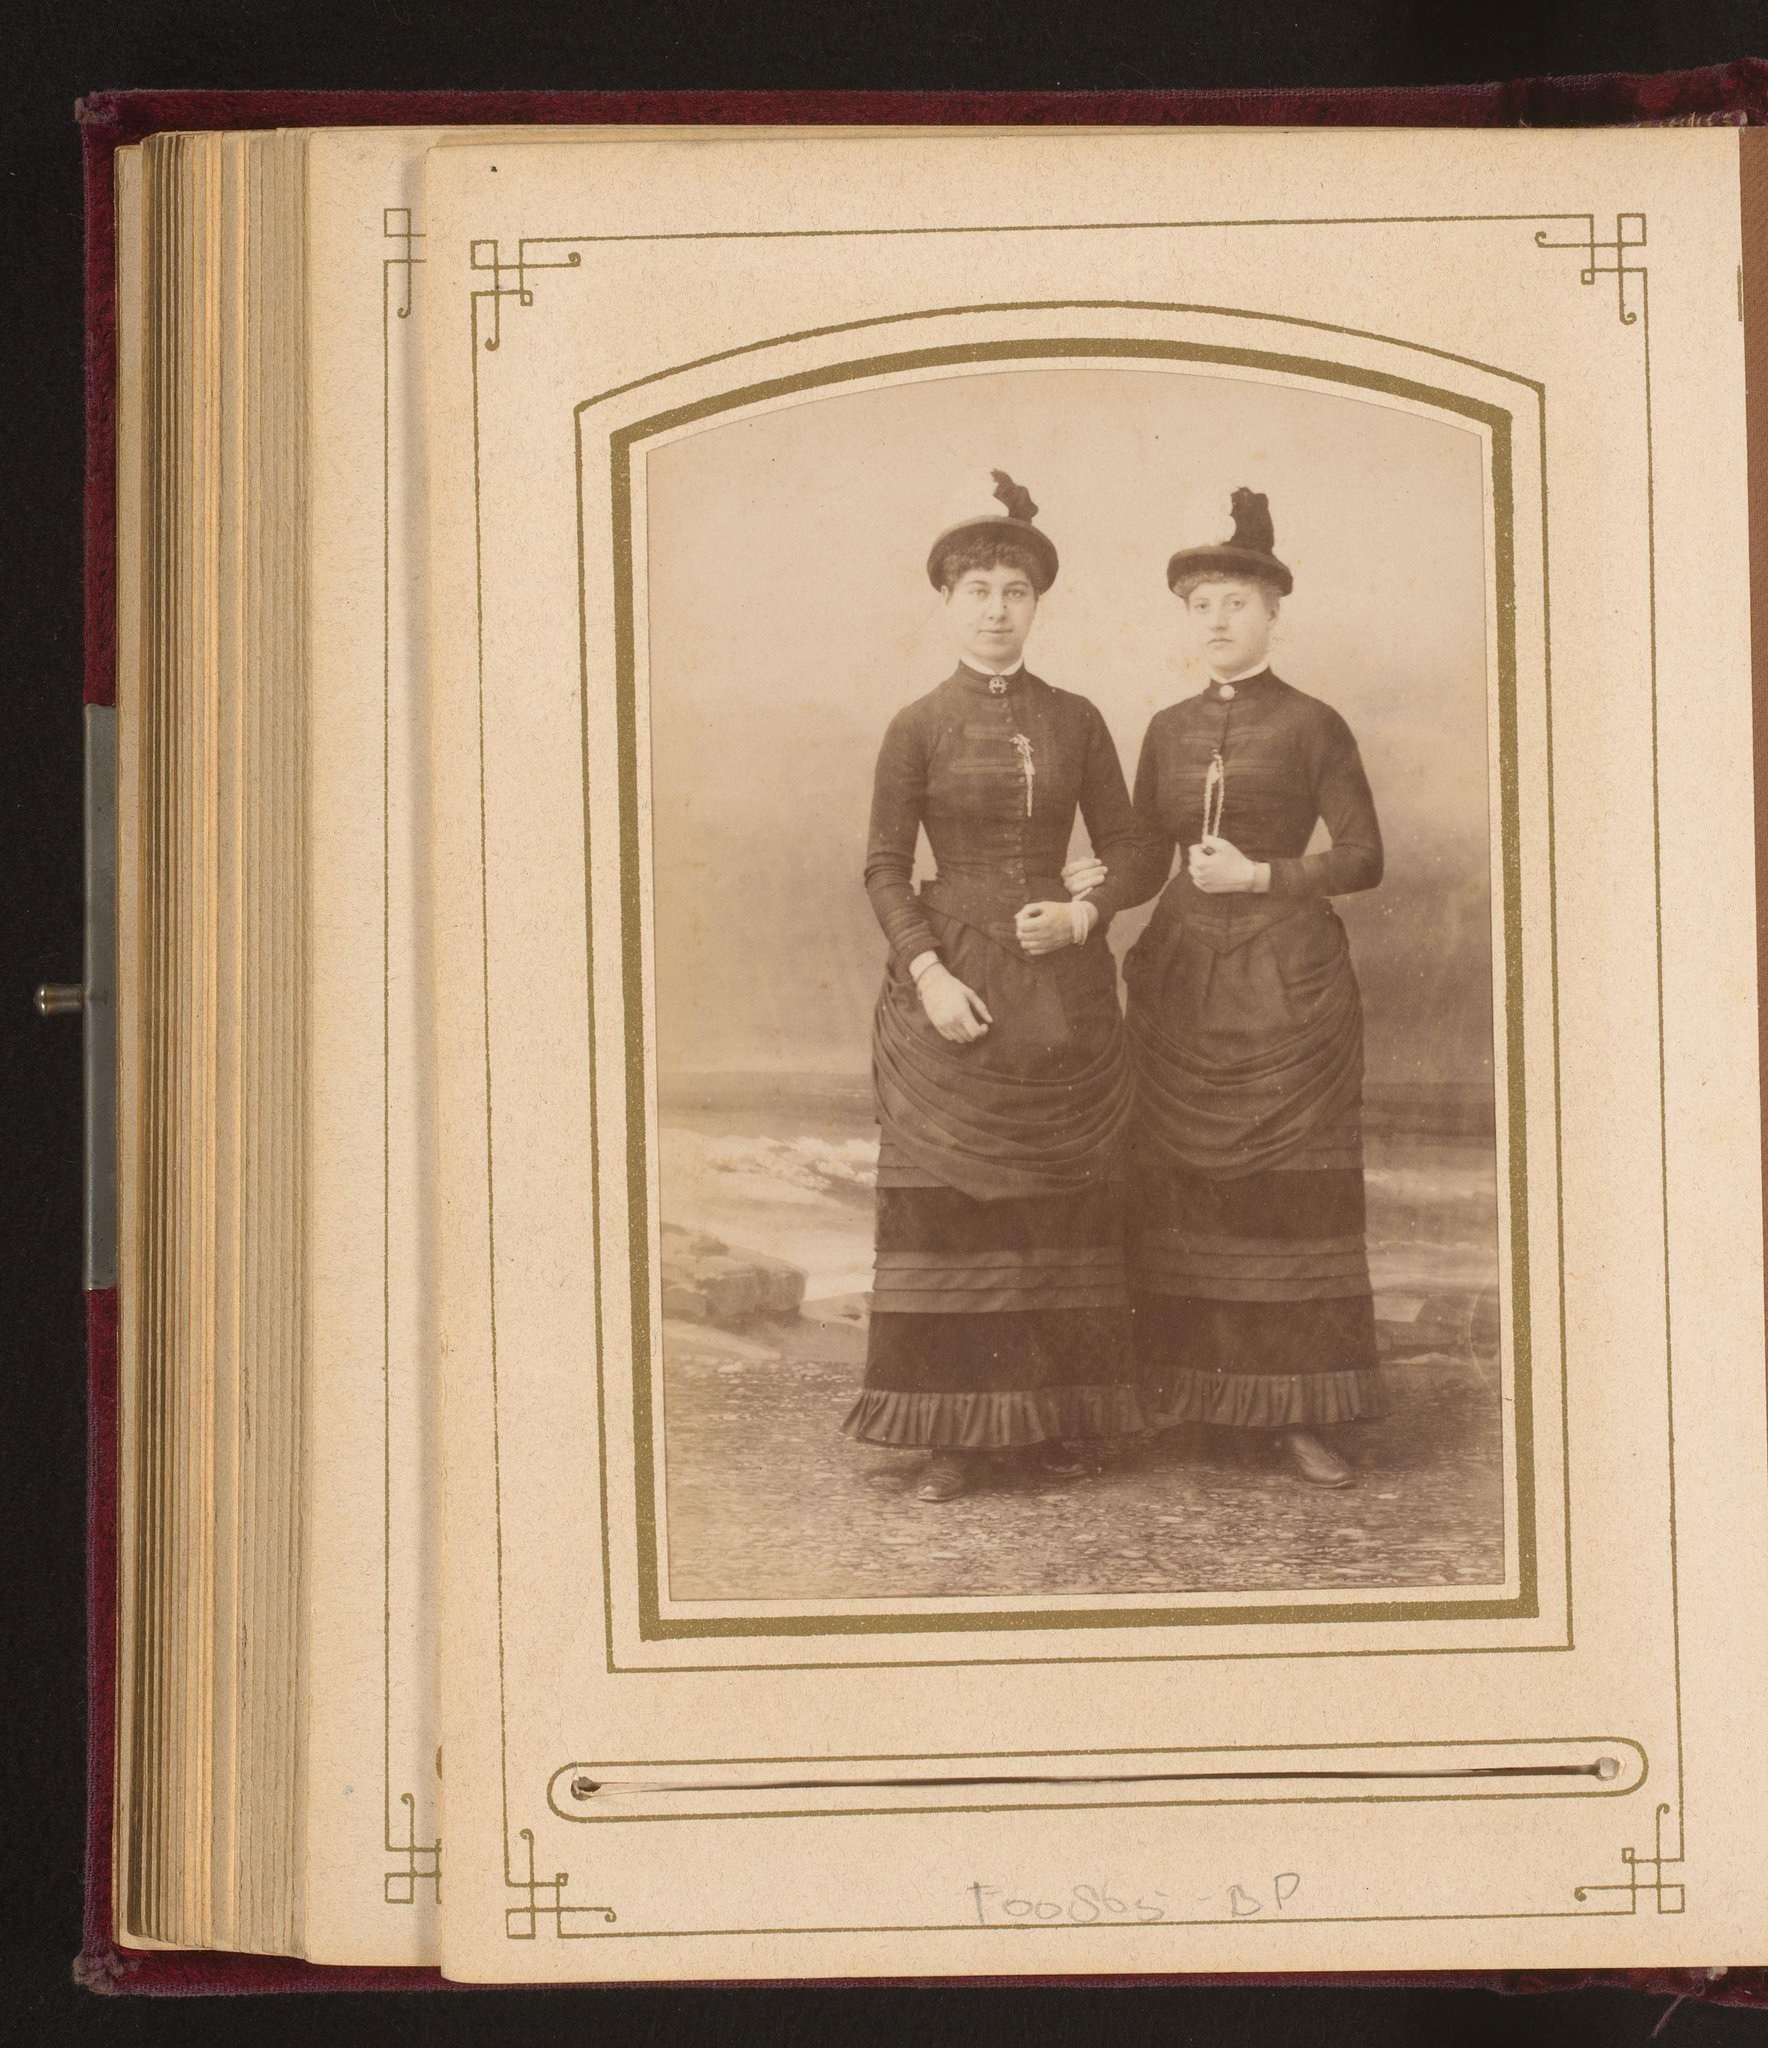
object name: carte de visite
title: Portret van twee vrouwen in dezelfde kleding en hoed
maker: Anonymous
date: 1880-1890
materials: cardboard, photographic support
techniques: albumen print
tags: historical persons - bb - woman, head-gear: hat, adult woman (+ two persons)